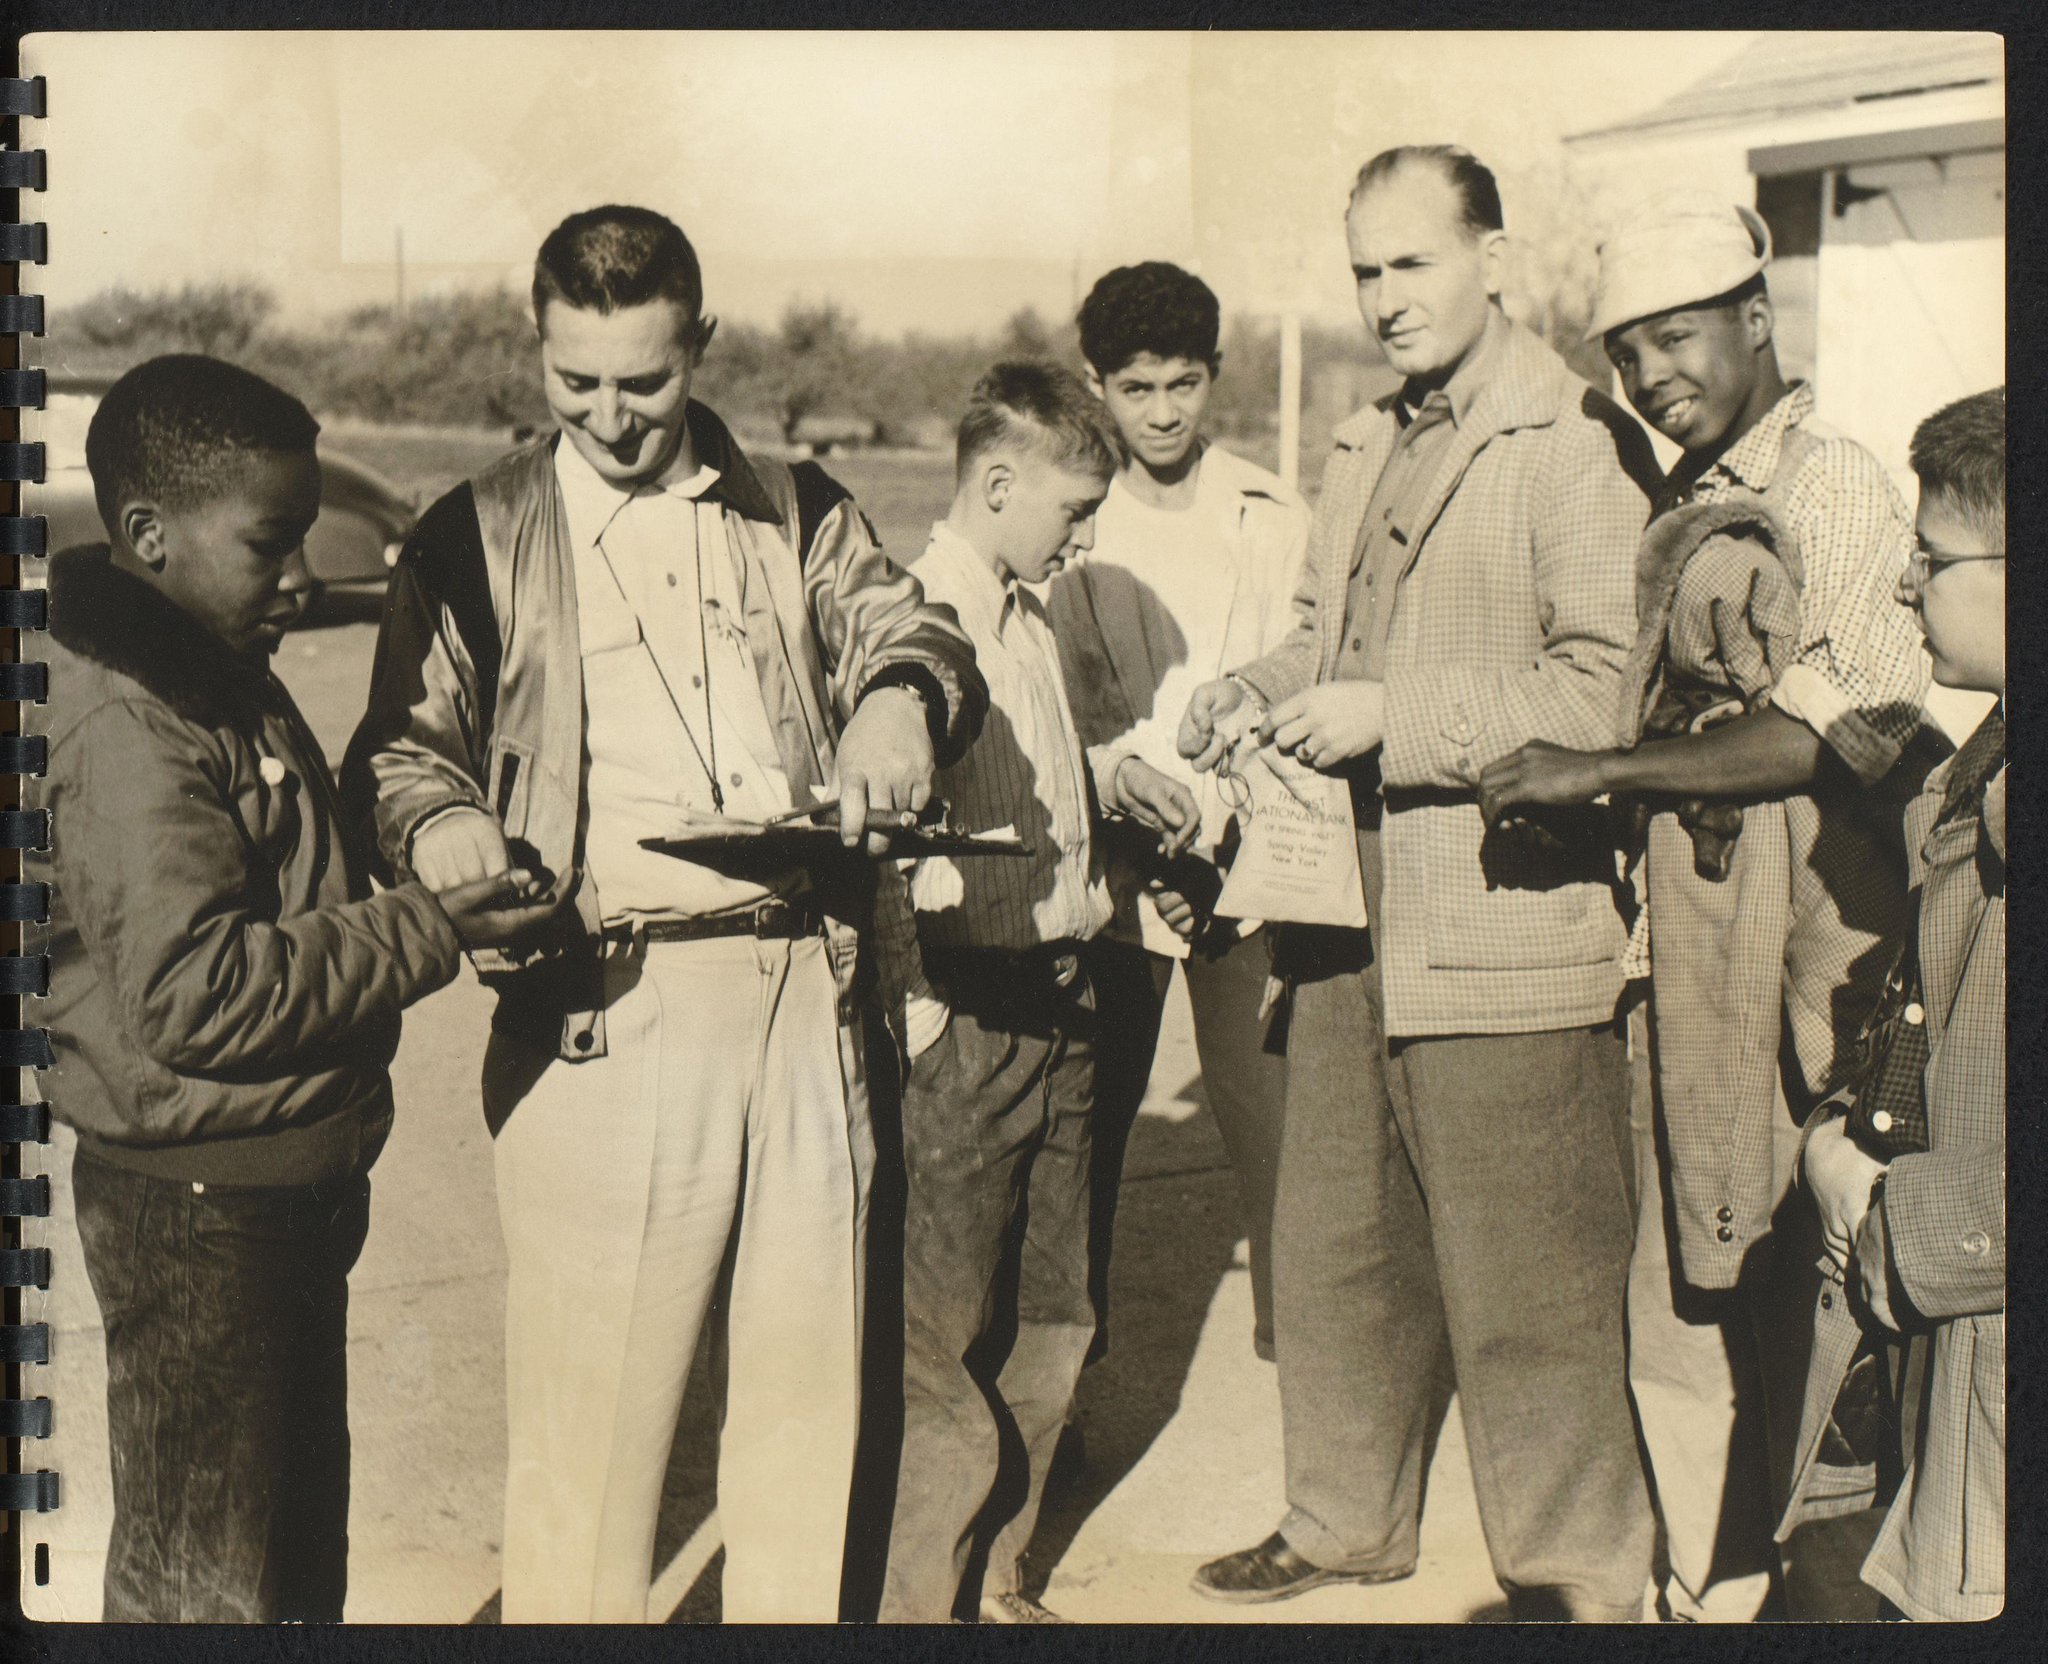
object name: photograph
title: Uitbetaling loon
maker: Anonymous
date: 1950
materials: paper, photographic support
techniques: gelatin silver print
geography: new york city